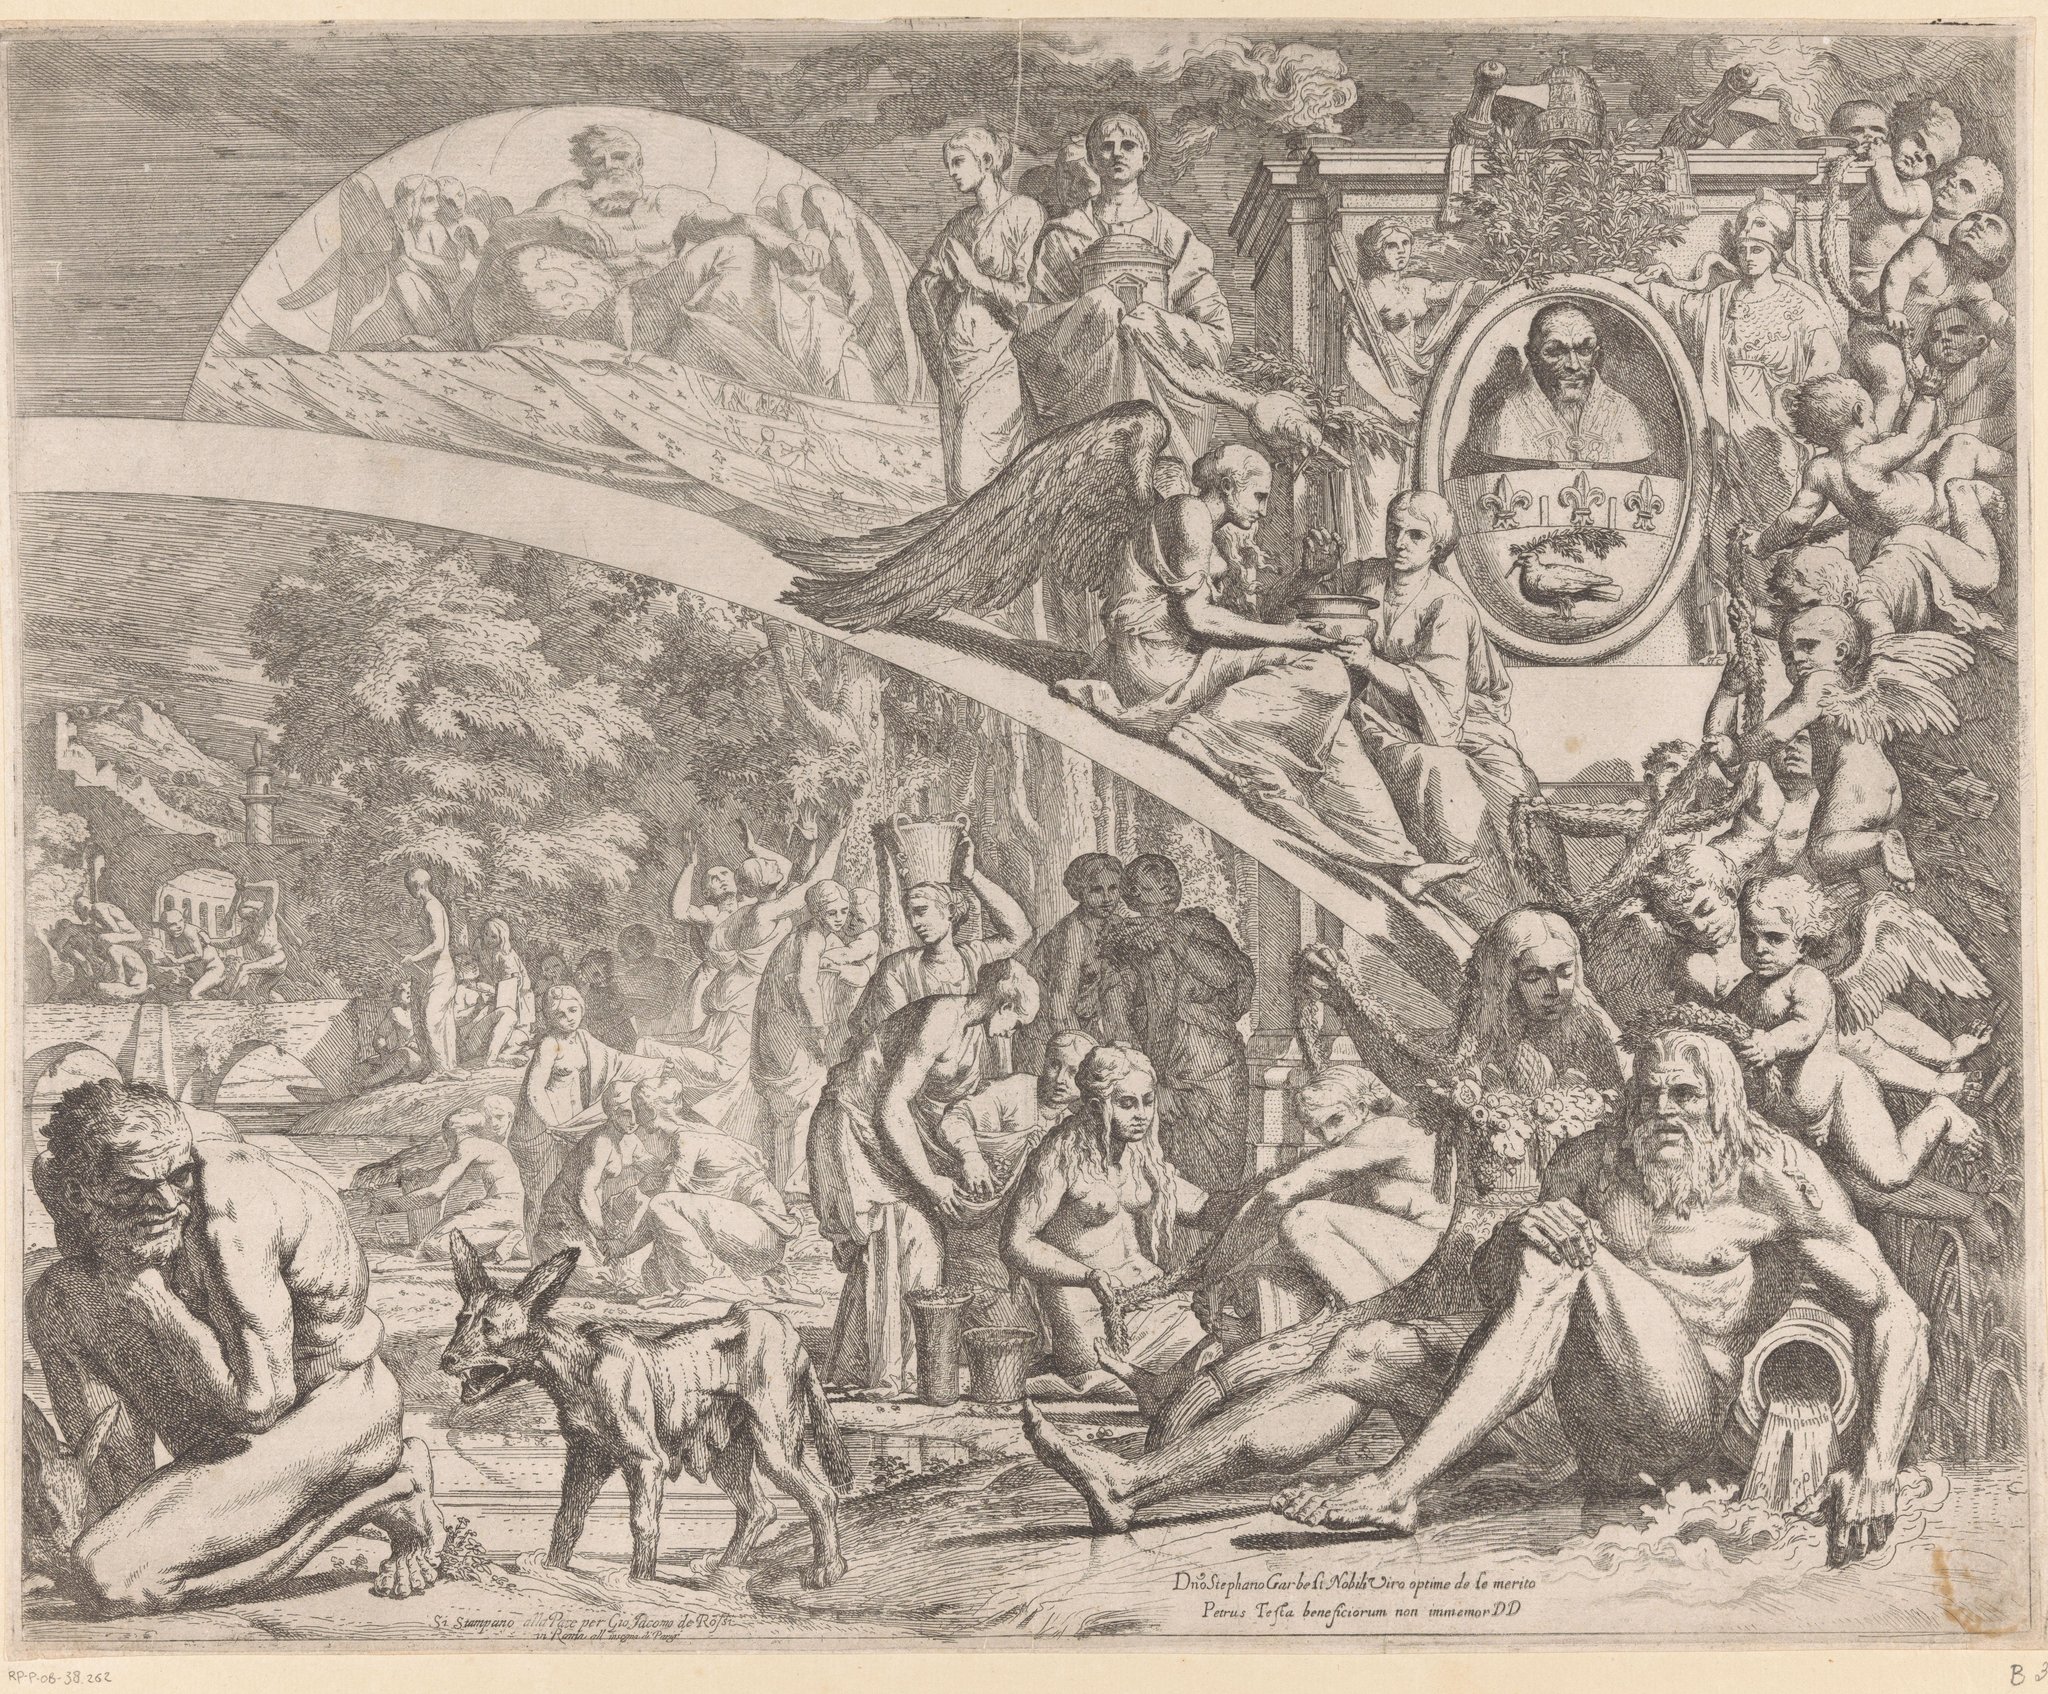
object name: print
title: Allegorie ter ere van paus Innocentius X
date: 1645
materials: paper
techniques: etching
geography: italy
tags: innocentius x, pope, rainbow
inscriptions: collector's mark: Lugt 240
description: Een allegorische voorstelling met rechtsboven het portret van paus Innocentius X. Opdracht rechtsonder.